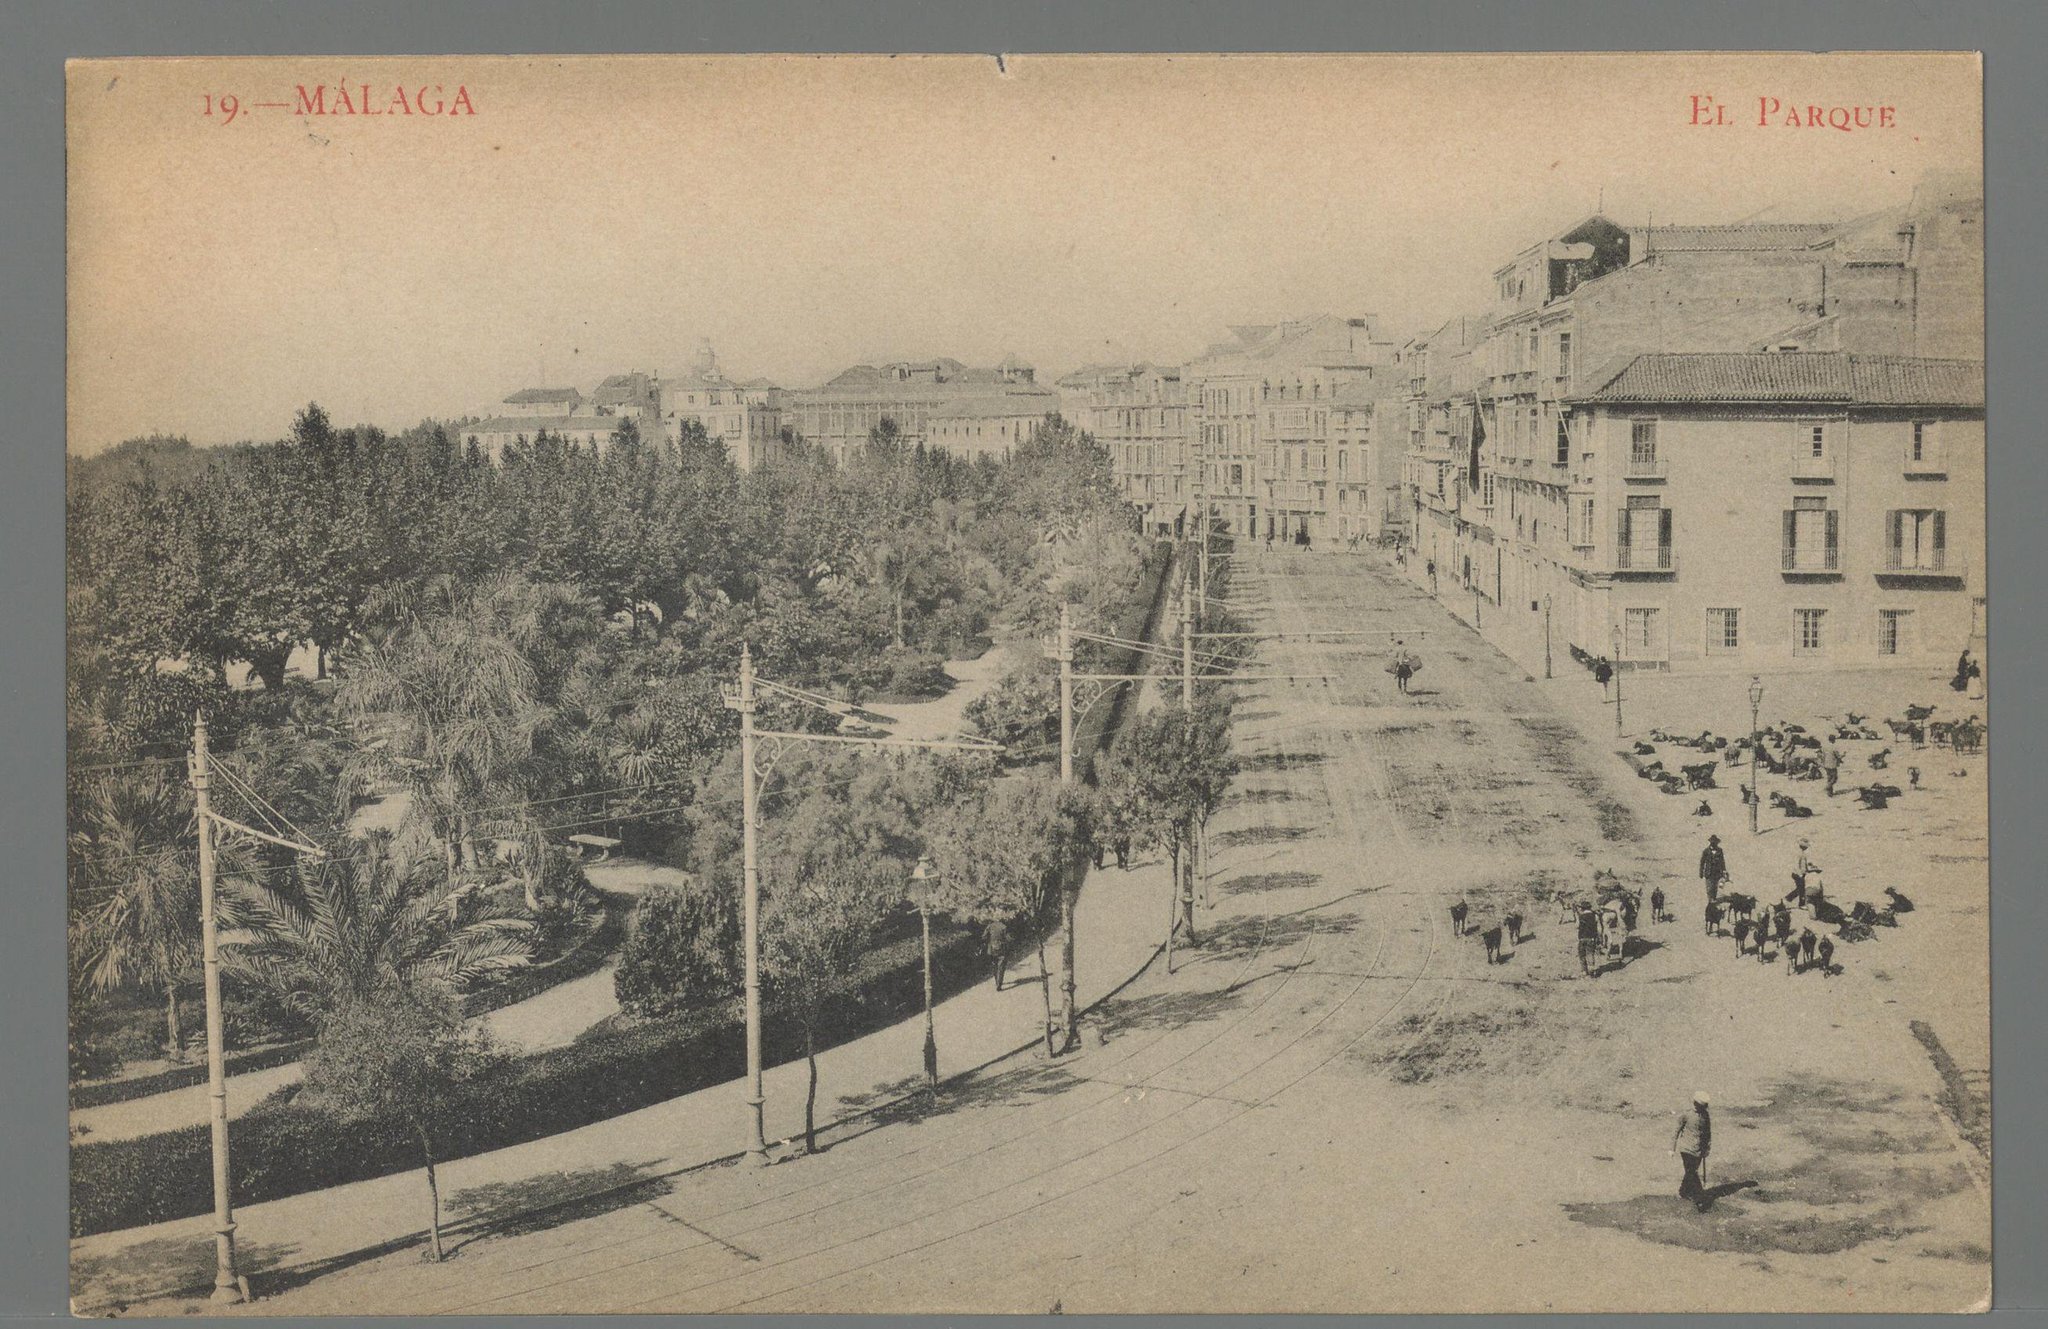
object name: photomechanical print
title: Málaga. El Parque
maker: Anonymous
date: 1906-1930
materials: cardboard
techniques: photograph, writing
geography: málaga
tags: park, street